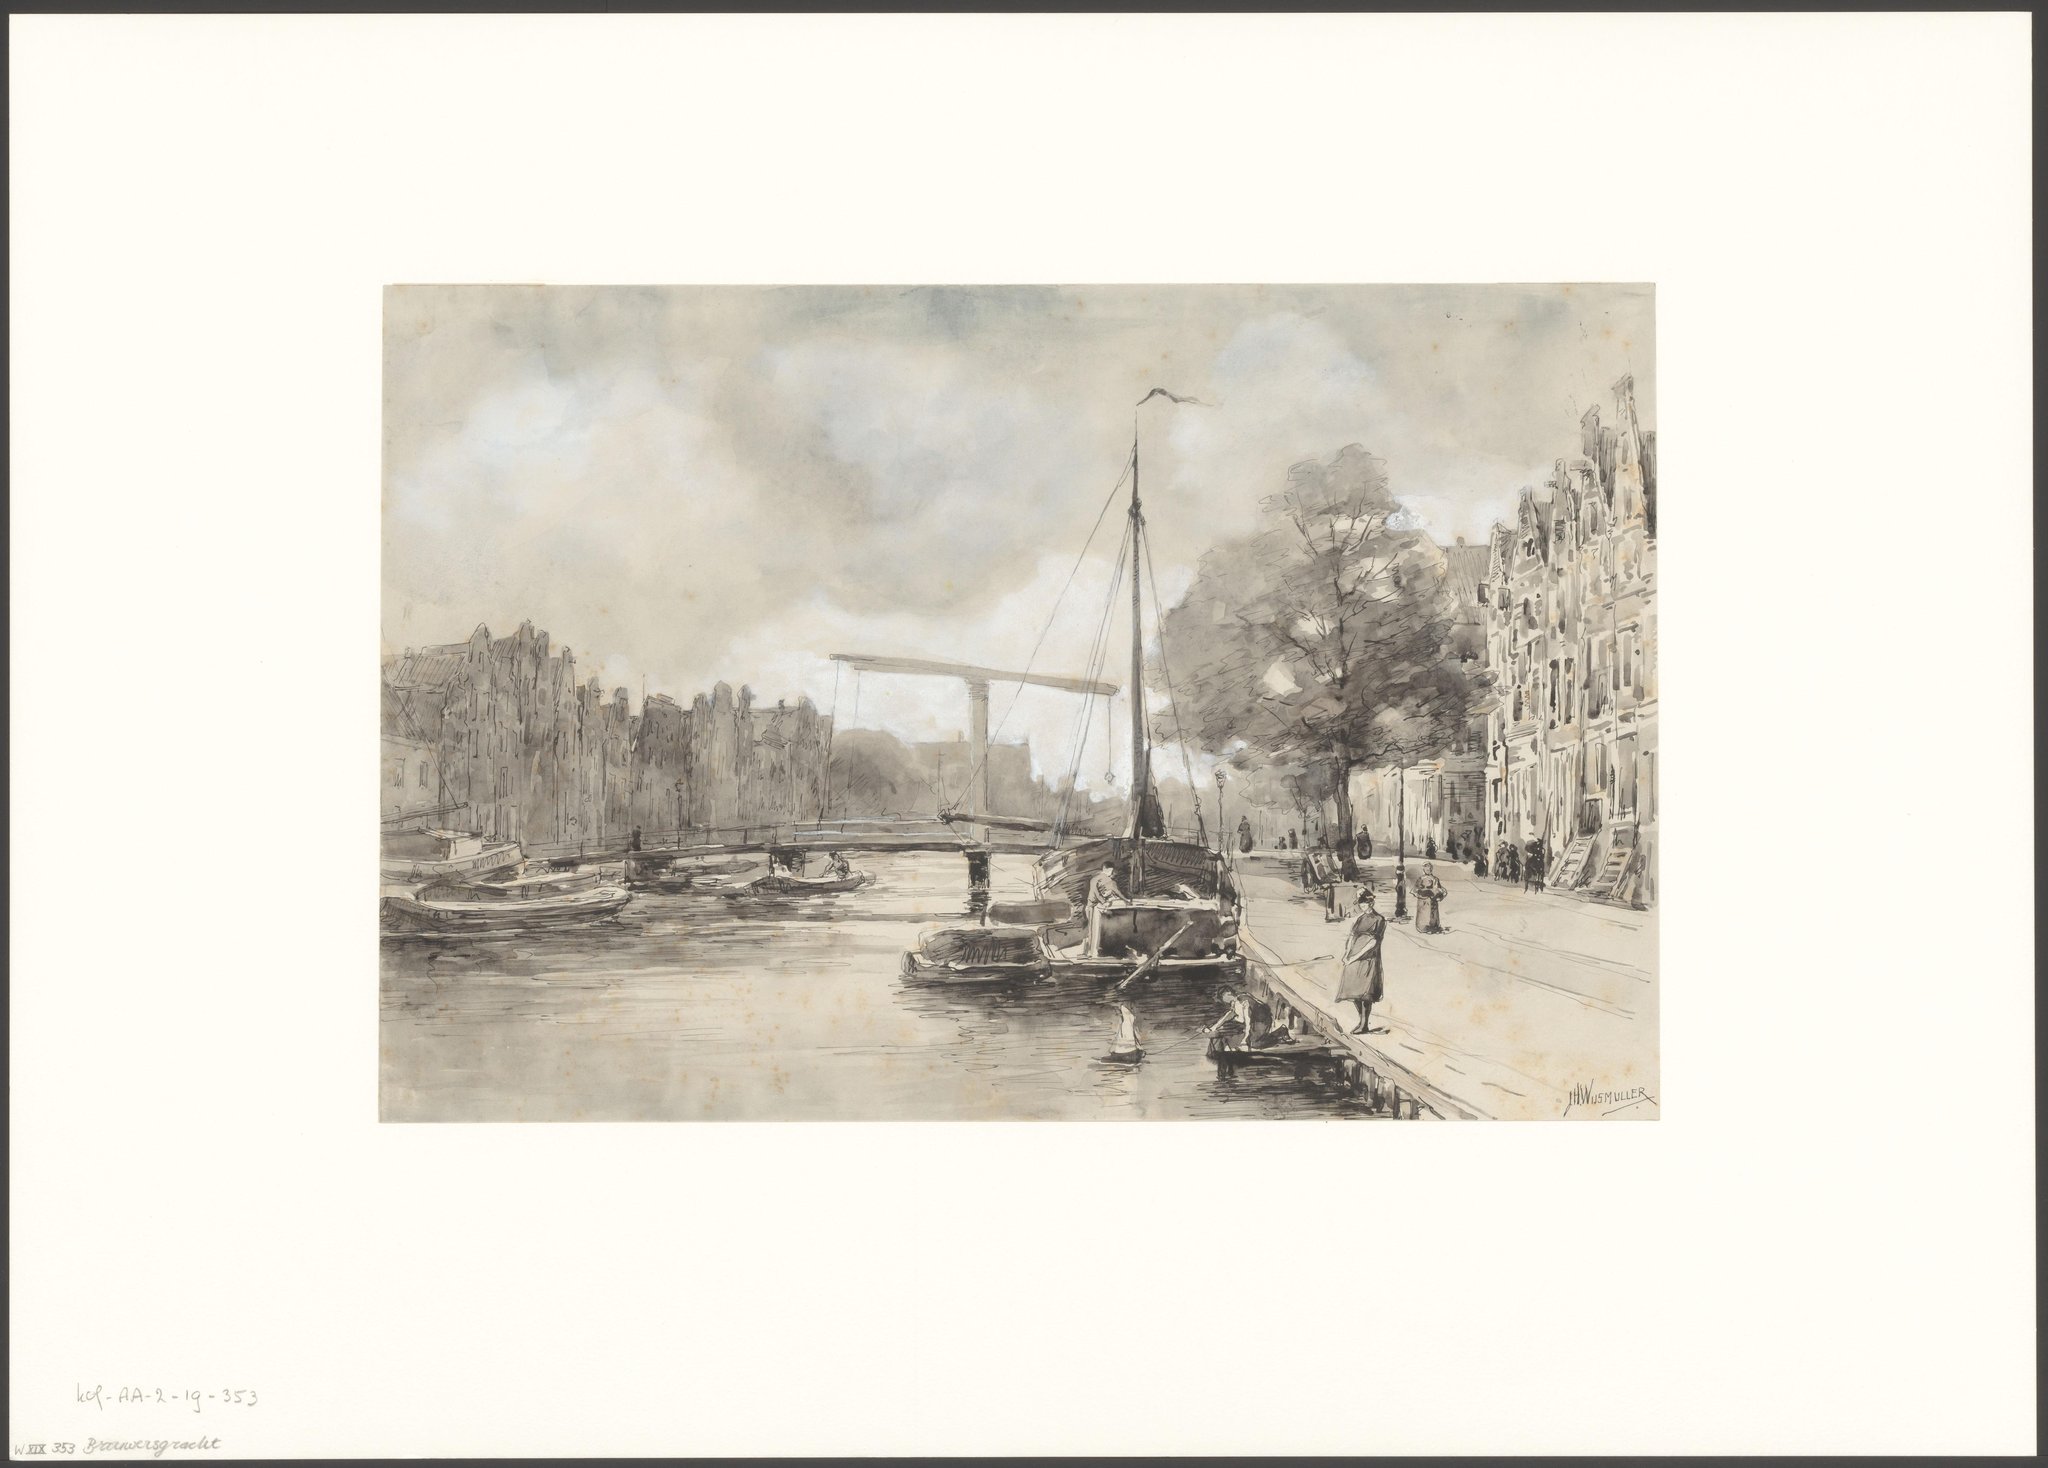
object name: drawing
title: Gezicht op de Brouwersgracht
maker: jan hillebrand wijsmuller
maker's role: painter, print maker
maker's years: 1855-1925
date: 1865-1925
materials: paint, ink, paper, pencil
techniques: brush, pen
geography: amsterdam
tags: city-view in general; 'veduta', canal, bridge in city across river, canal, etc.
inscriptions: collector's mark: Lugt 800a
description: Tekening binnen de Atlas Van Eck ingedeeld op wijknummer 19.